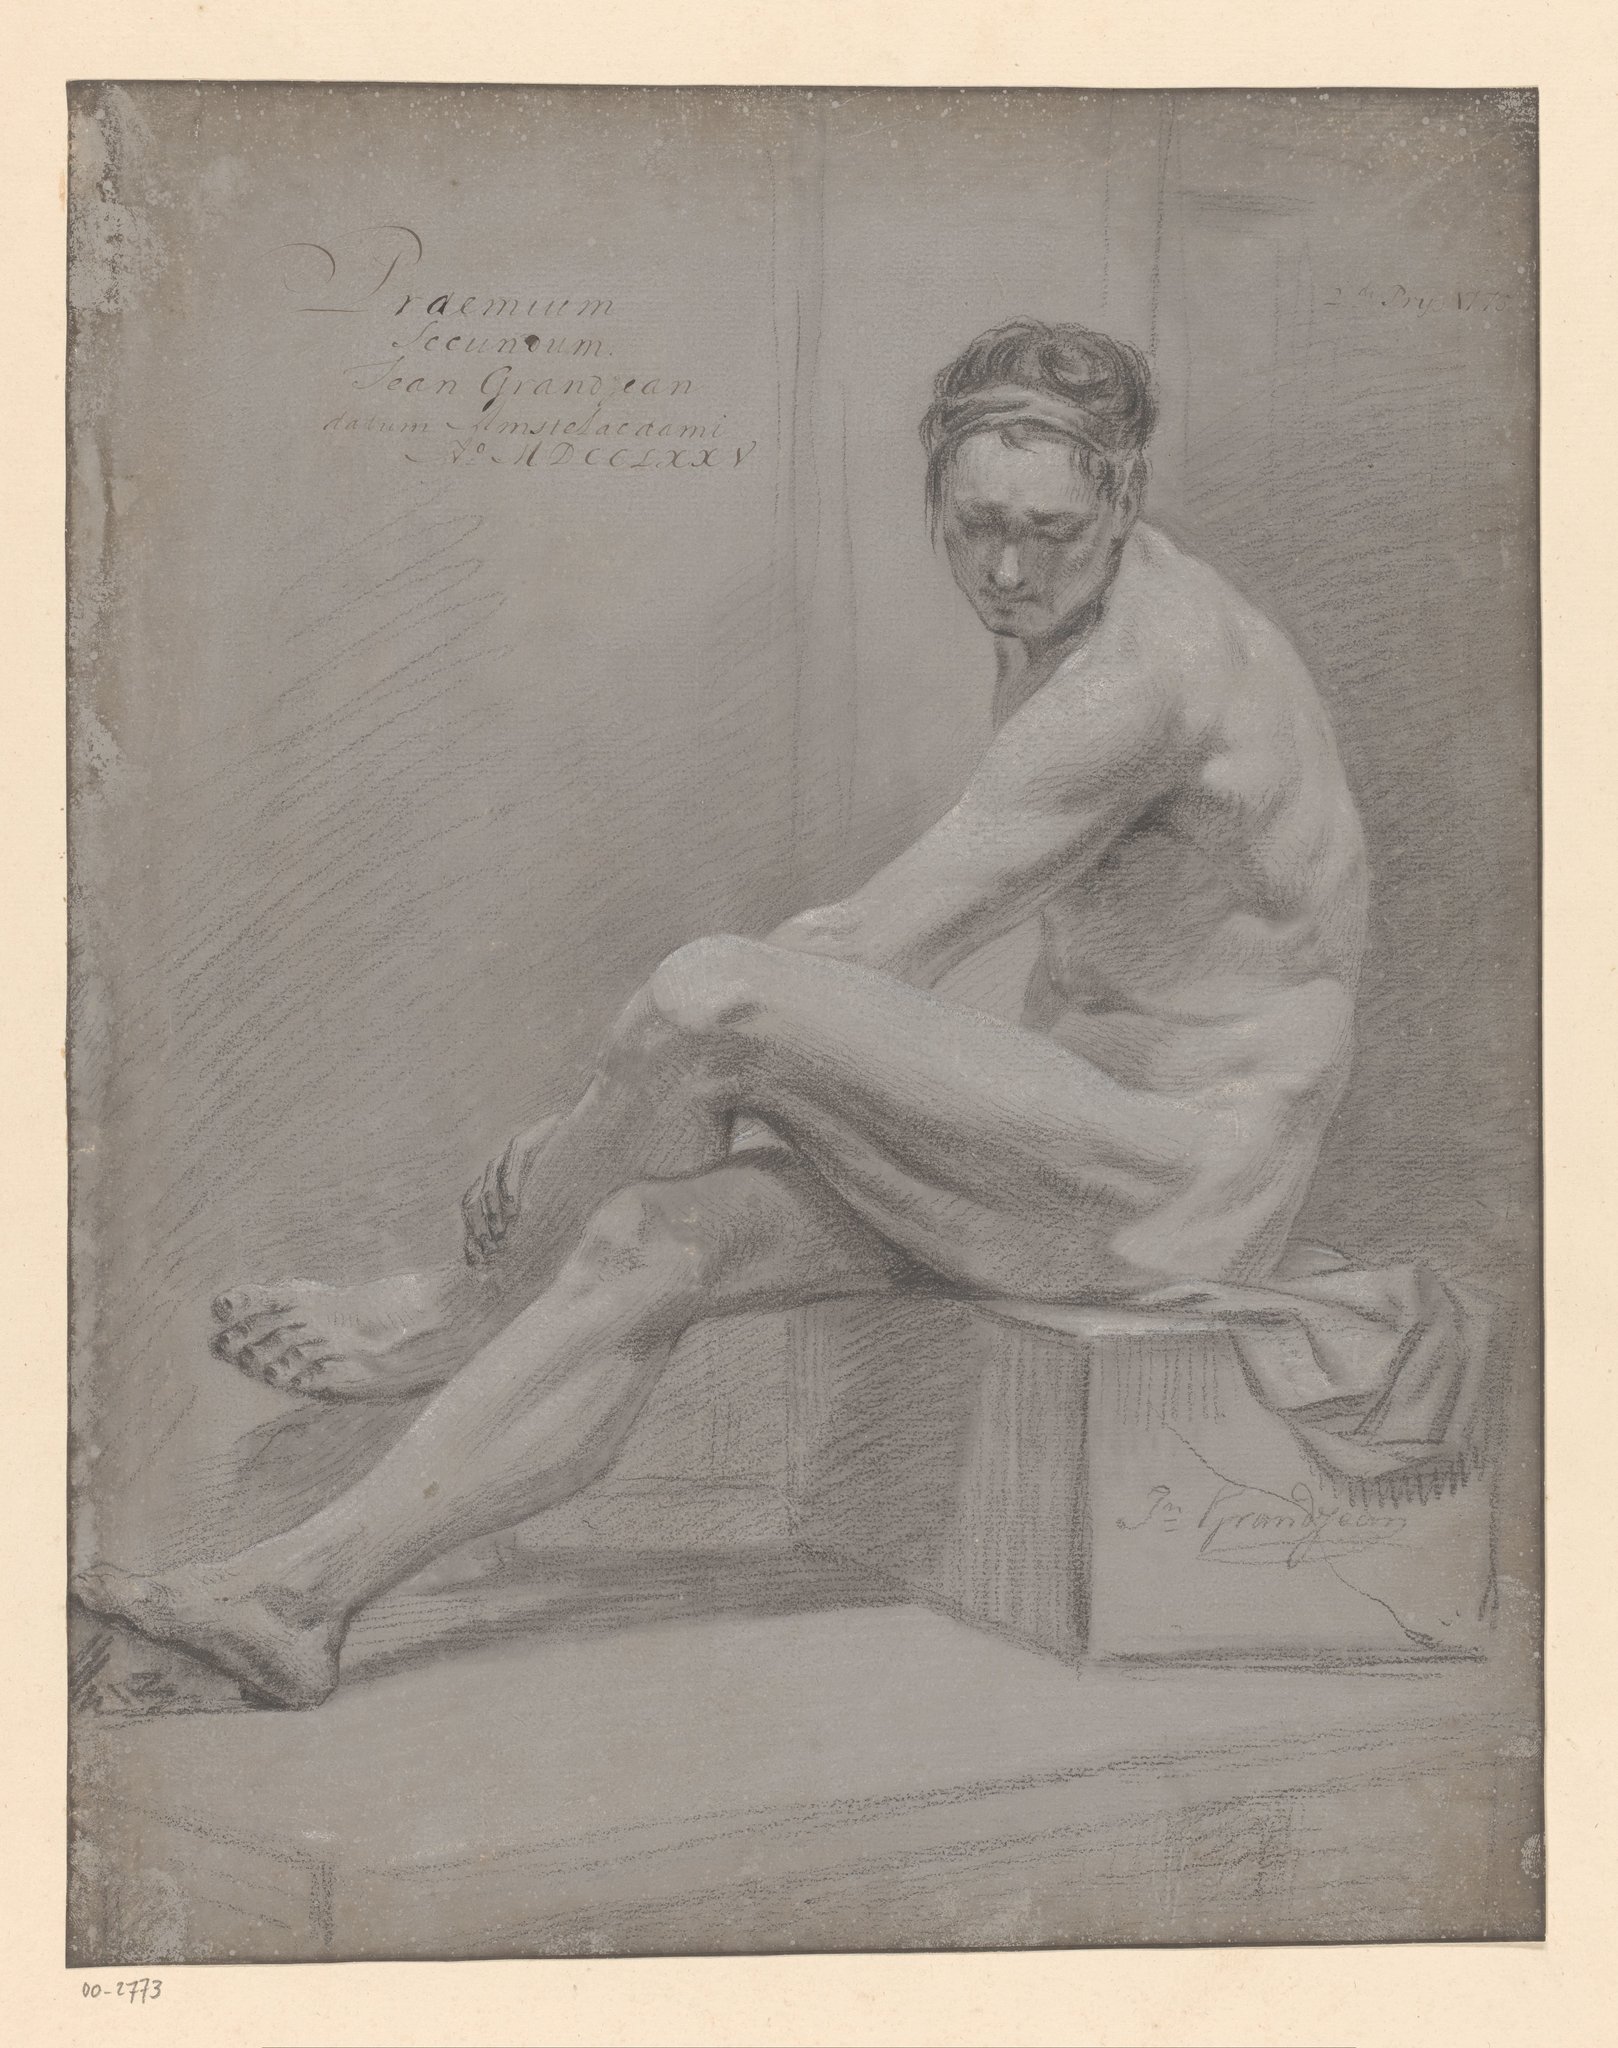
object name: drawing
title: Zittend mannelijk naakt, van opzij gezien (2e prijs 1775)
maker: jean grandjean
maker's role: draughtsman, print maker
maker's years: 1752-1781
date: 1775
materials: chalk, paper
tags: sitting figure (+ nude human being)